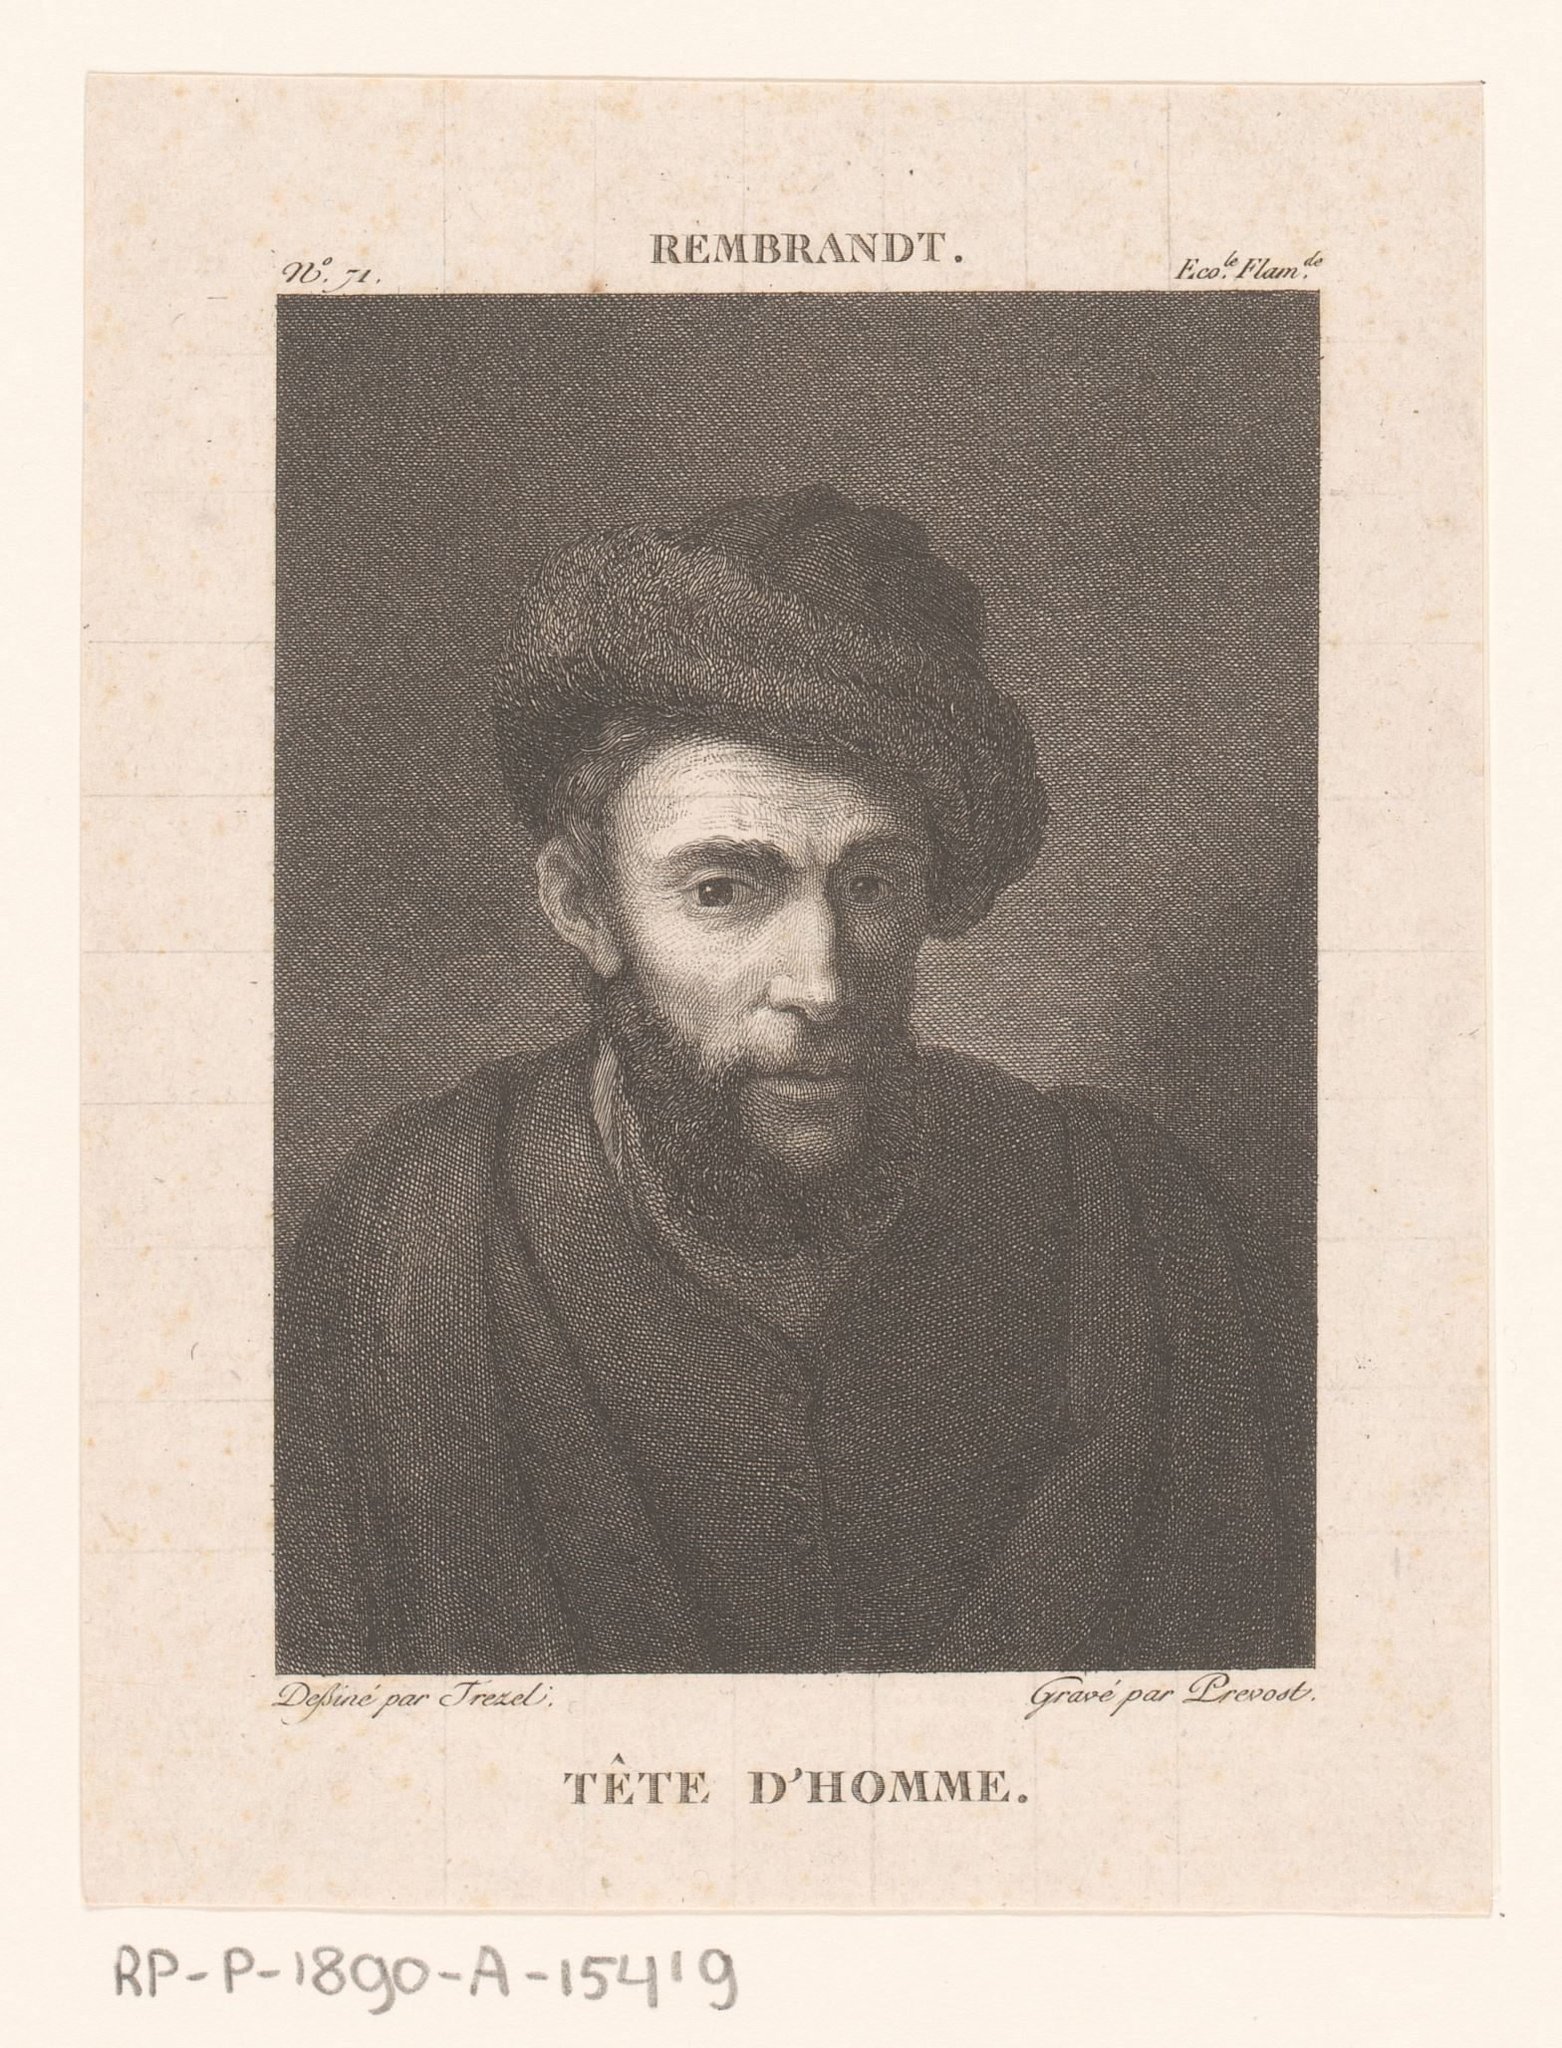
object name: print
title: Tête d'homme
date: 1757-1809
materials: paper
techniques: etching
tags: adult man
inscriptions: collector's mark: Lugt 2228